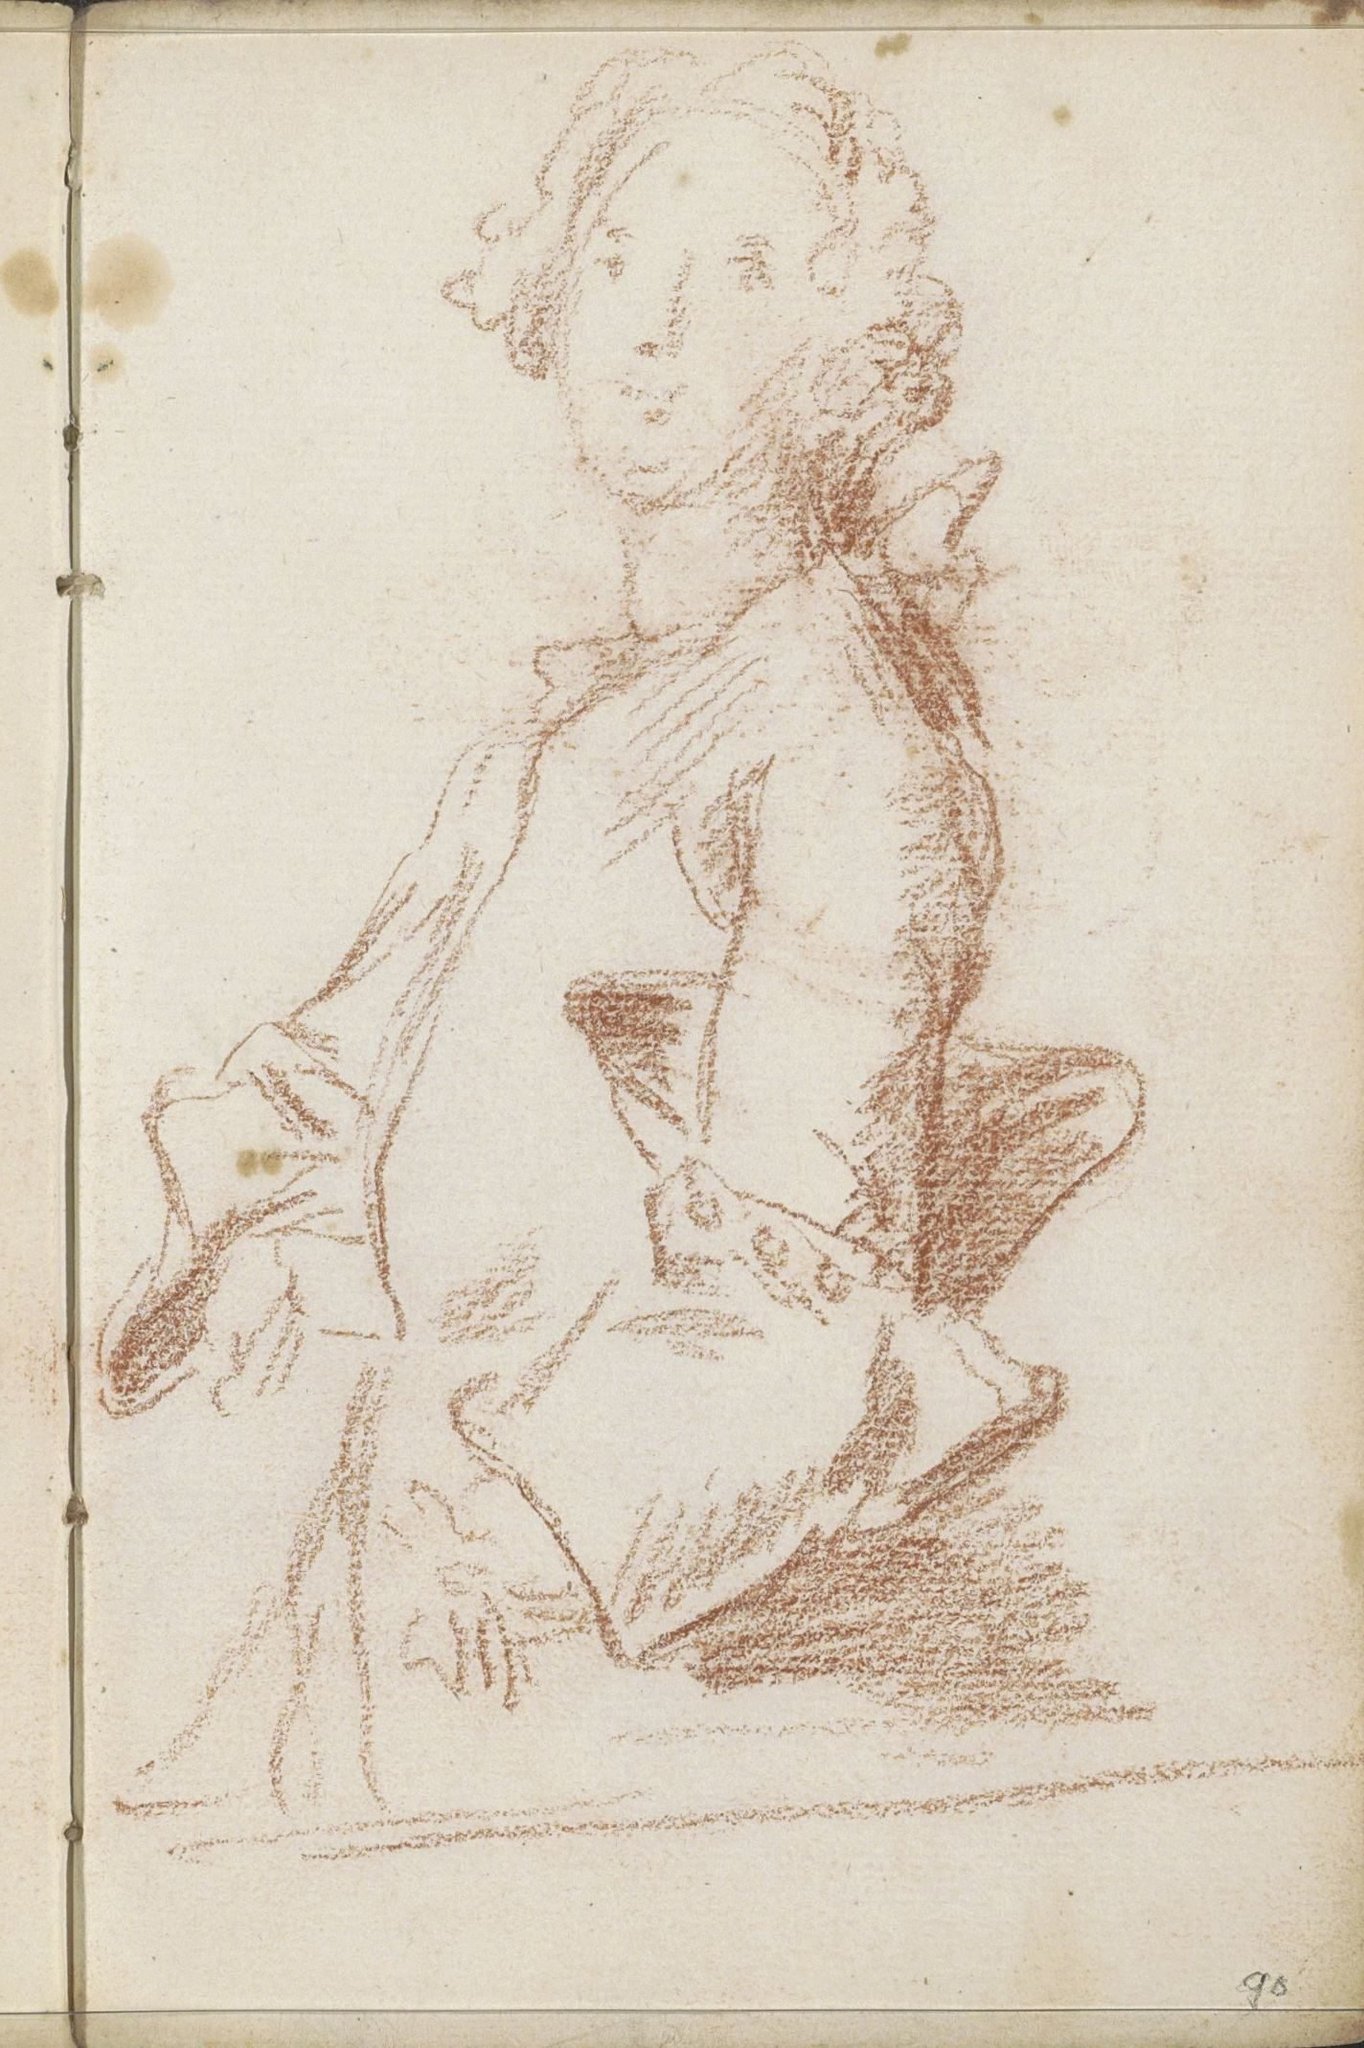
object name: sketchbook leaf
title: Staande man met de hand op de heup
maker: petrus johannes van reysschoot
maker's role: draughtsman, print maker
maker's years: 1702-1772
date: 1710-1772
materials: chalk, paper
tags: standing figure, hand on the hip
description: Blad 90 recto uit een schetsboek met 105 bladen.